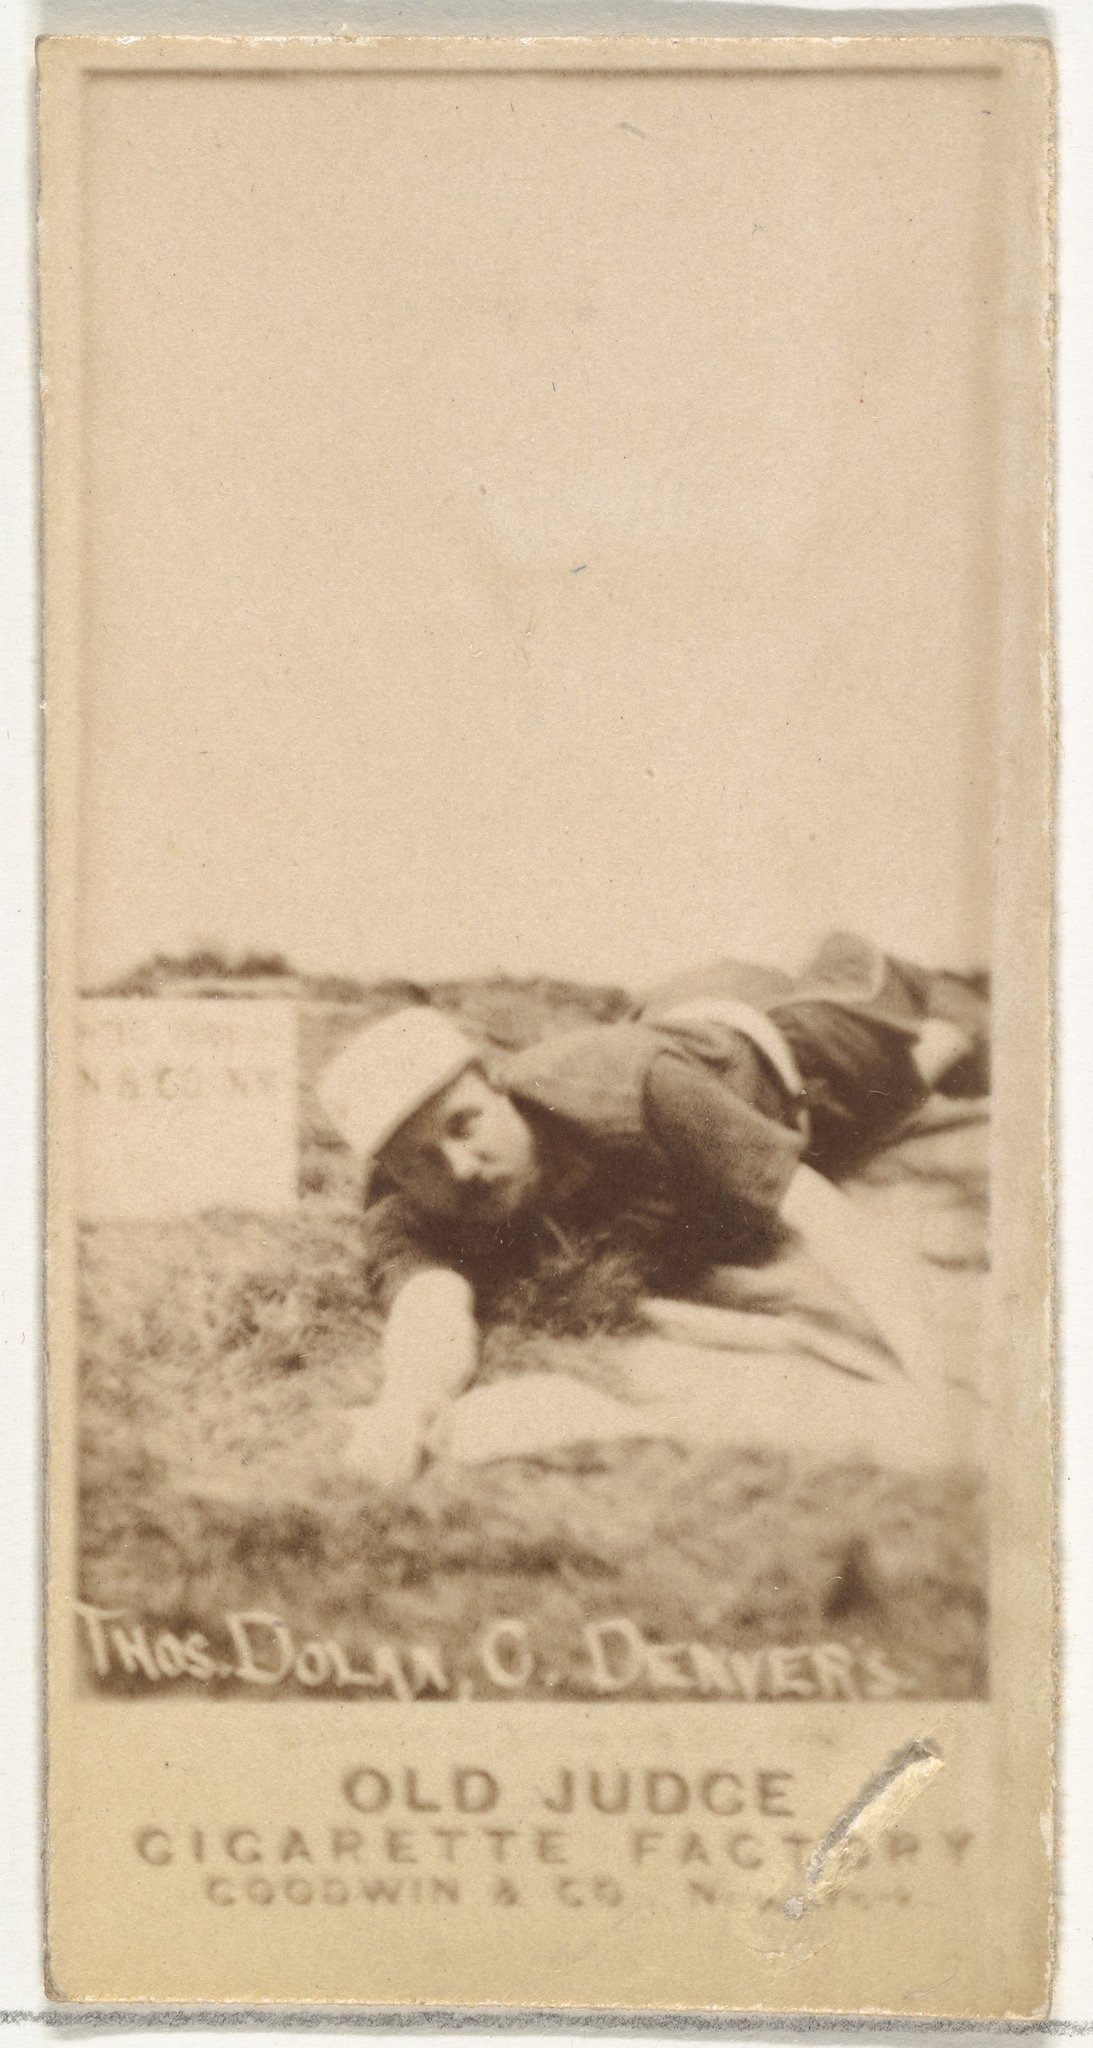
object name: baseball card, photograph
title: Thomas J. "Tom" Dolan, Catcher, Denver, from the Old Judge series (N172) for Old Judge Cigarettes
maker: goodwin & company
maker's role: publisher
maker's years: 1850-1950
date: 1888-1889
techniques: albumen silver print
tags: men,portraits,baseball,athletes